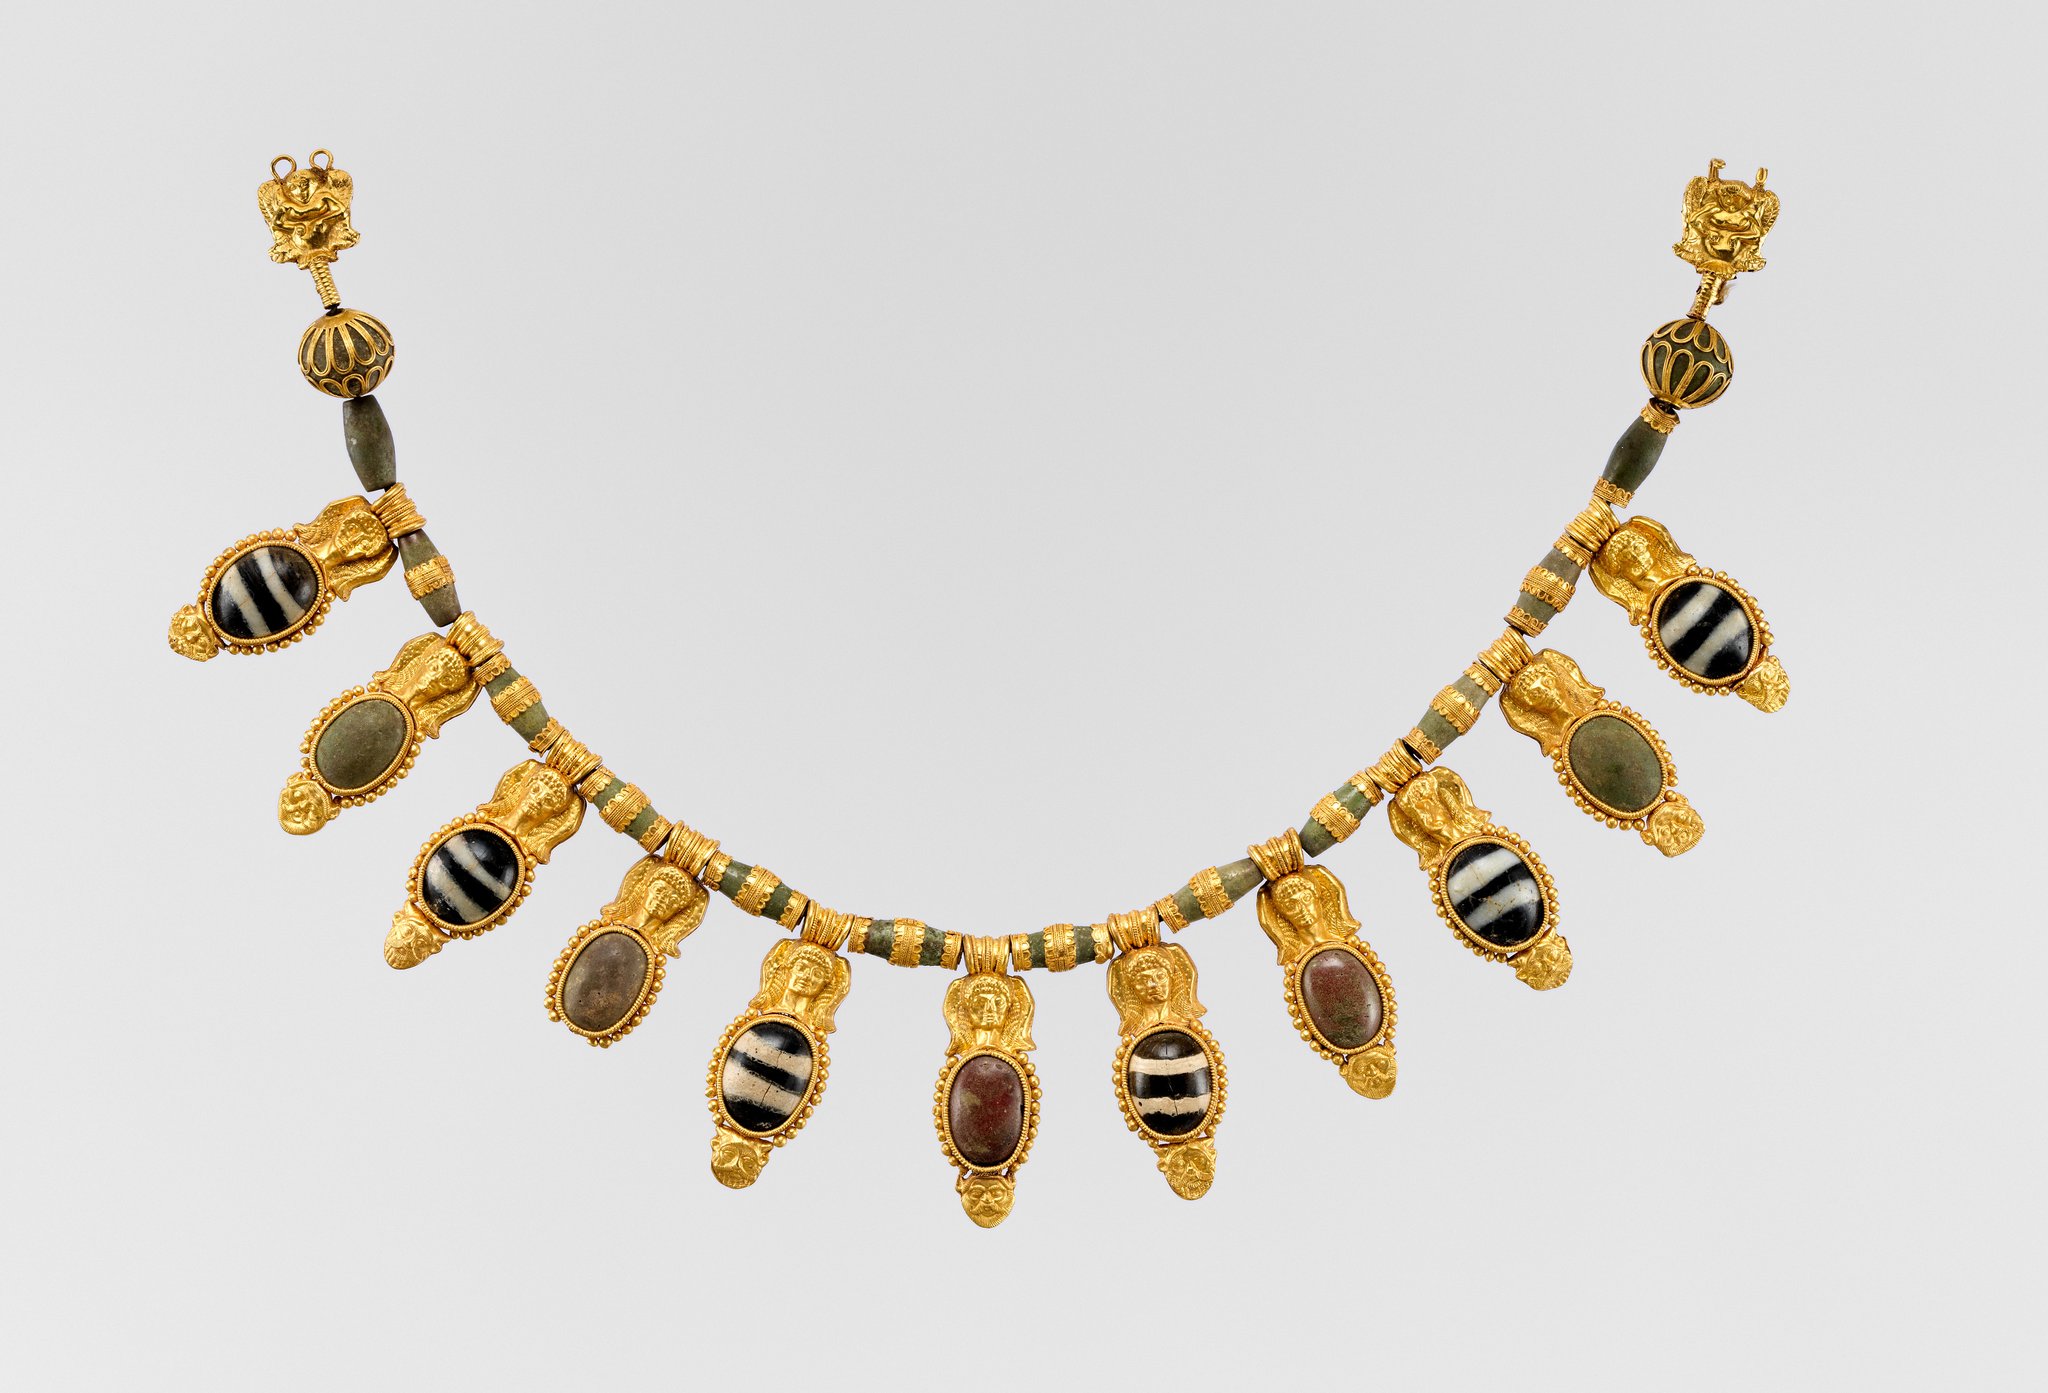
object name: necklace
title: Gold and glass necklace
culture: etruscan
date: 500-468 BCE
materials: glass, gold